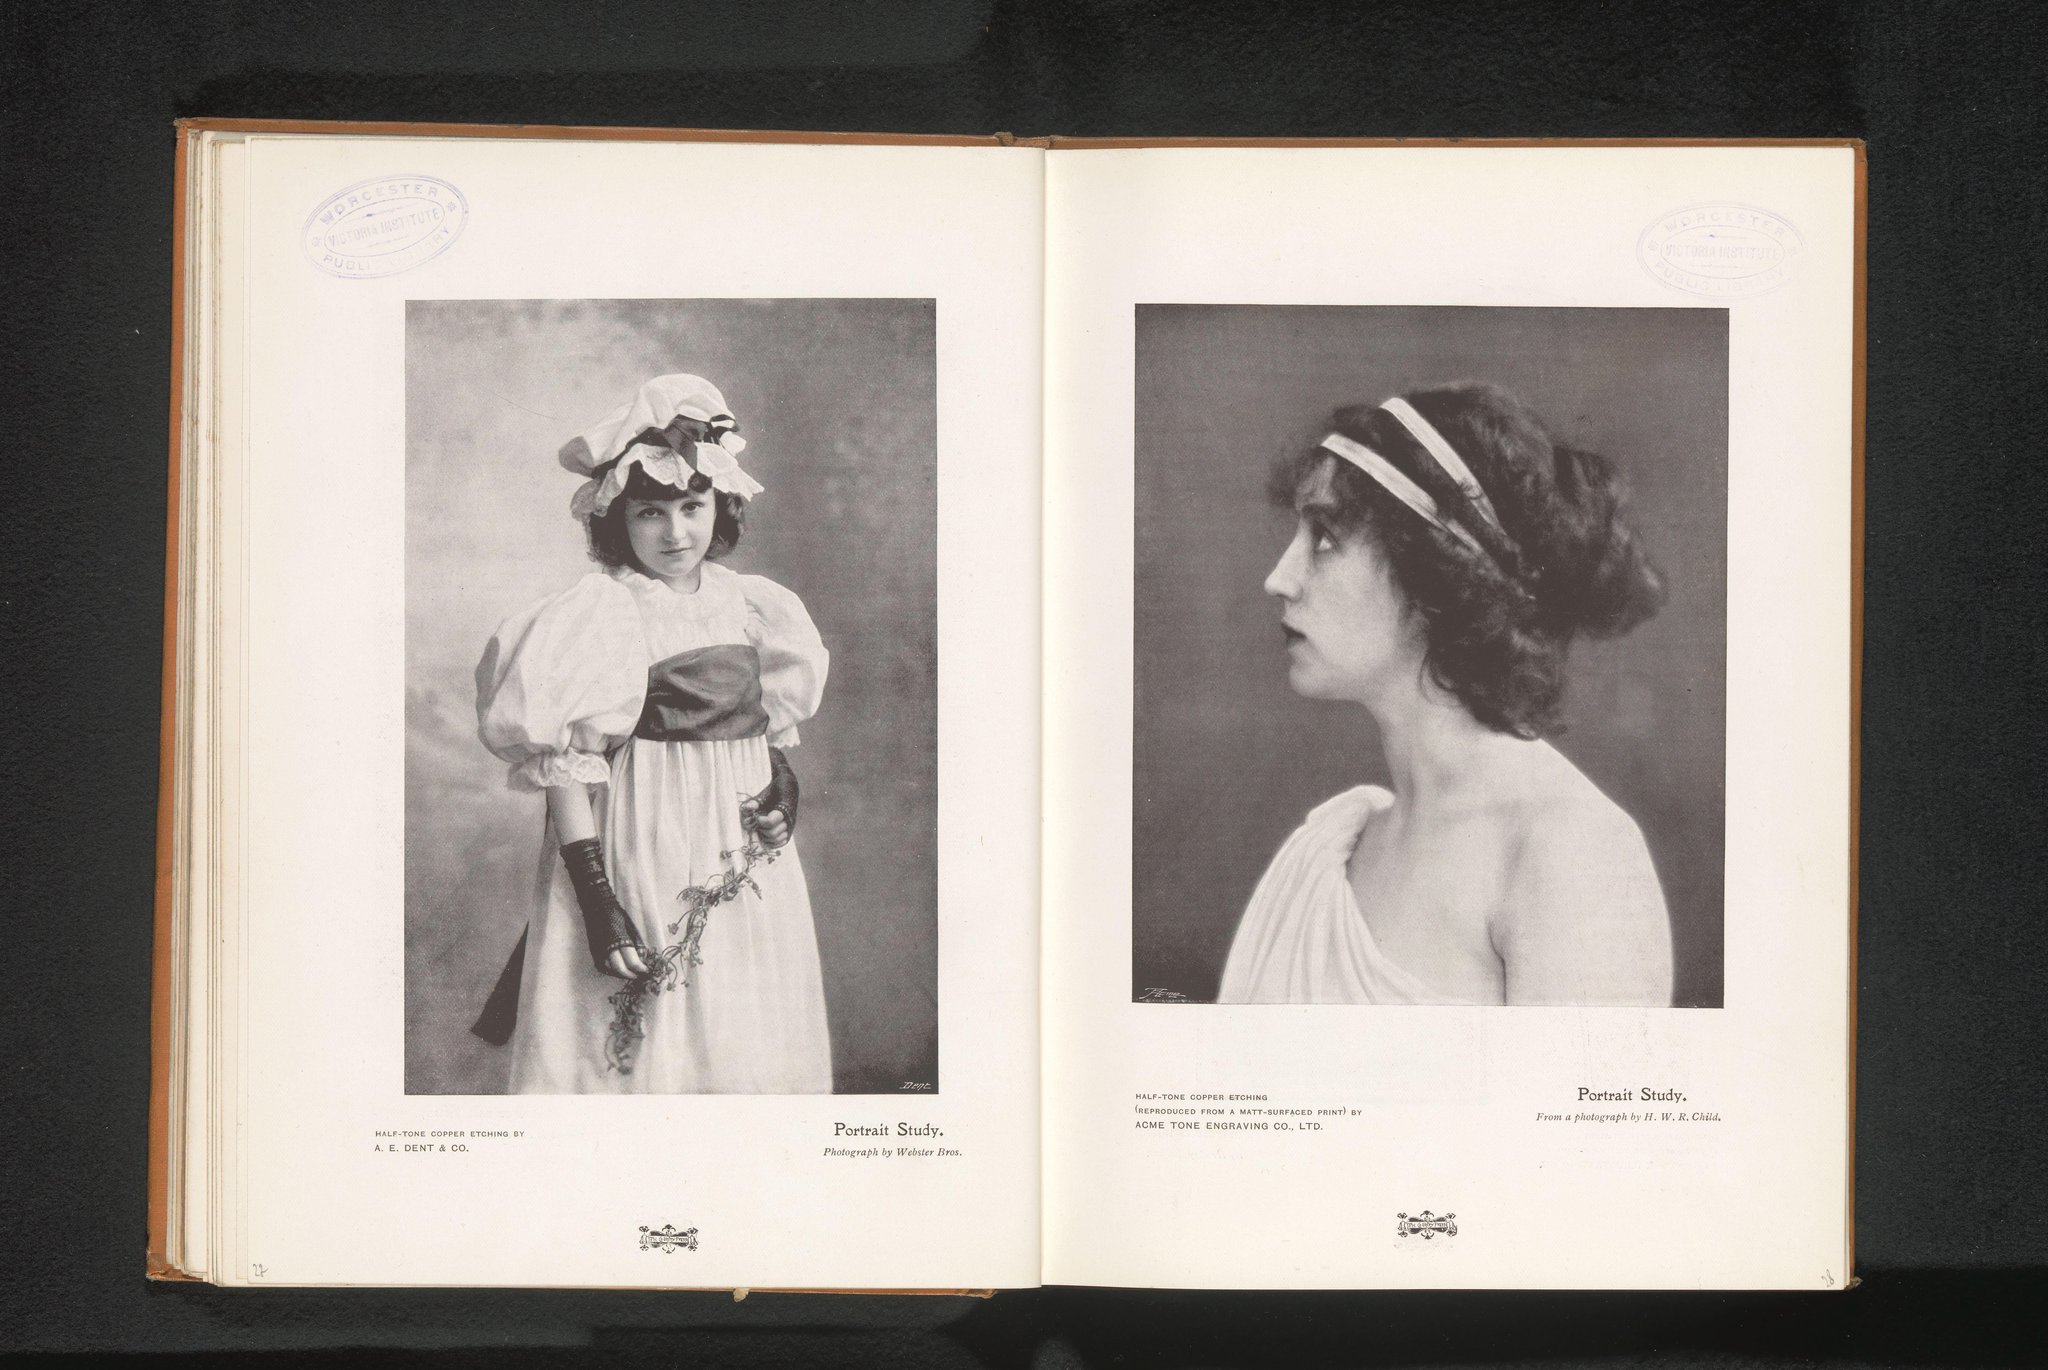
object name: photomechanical print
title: Portret van een onbekende vrouw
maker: h.w.r. child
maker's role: fotograaf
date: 1894-1899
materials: paper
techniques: autotype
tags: historical persons - bb - woman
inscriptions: collector's mark: ‘Worcester Public Library/ Victoria's Institute’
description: Prent op derde ongenummerde pagina na pagina 40.